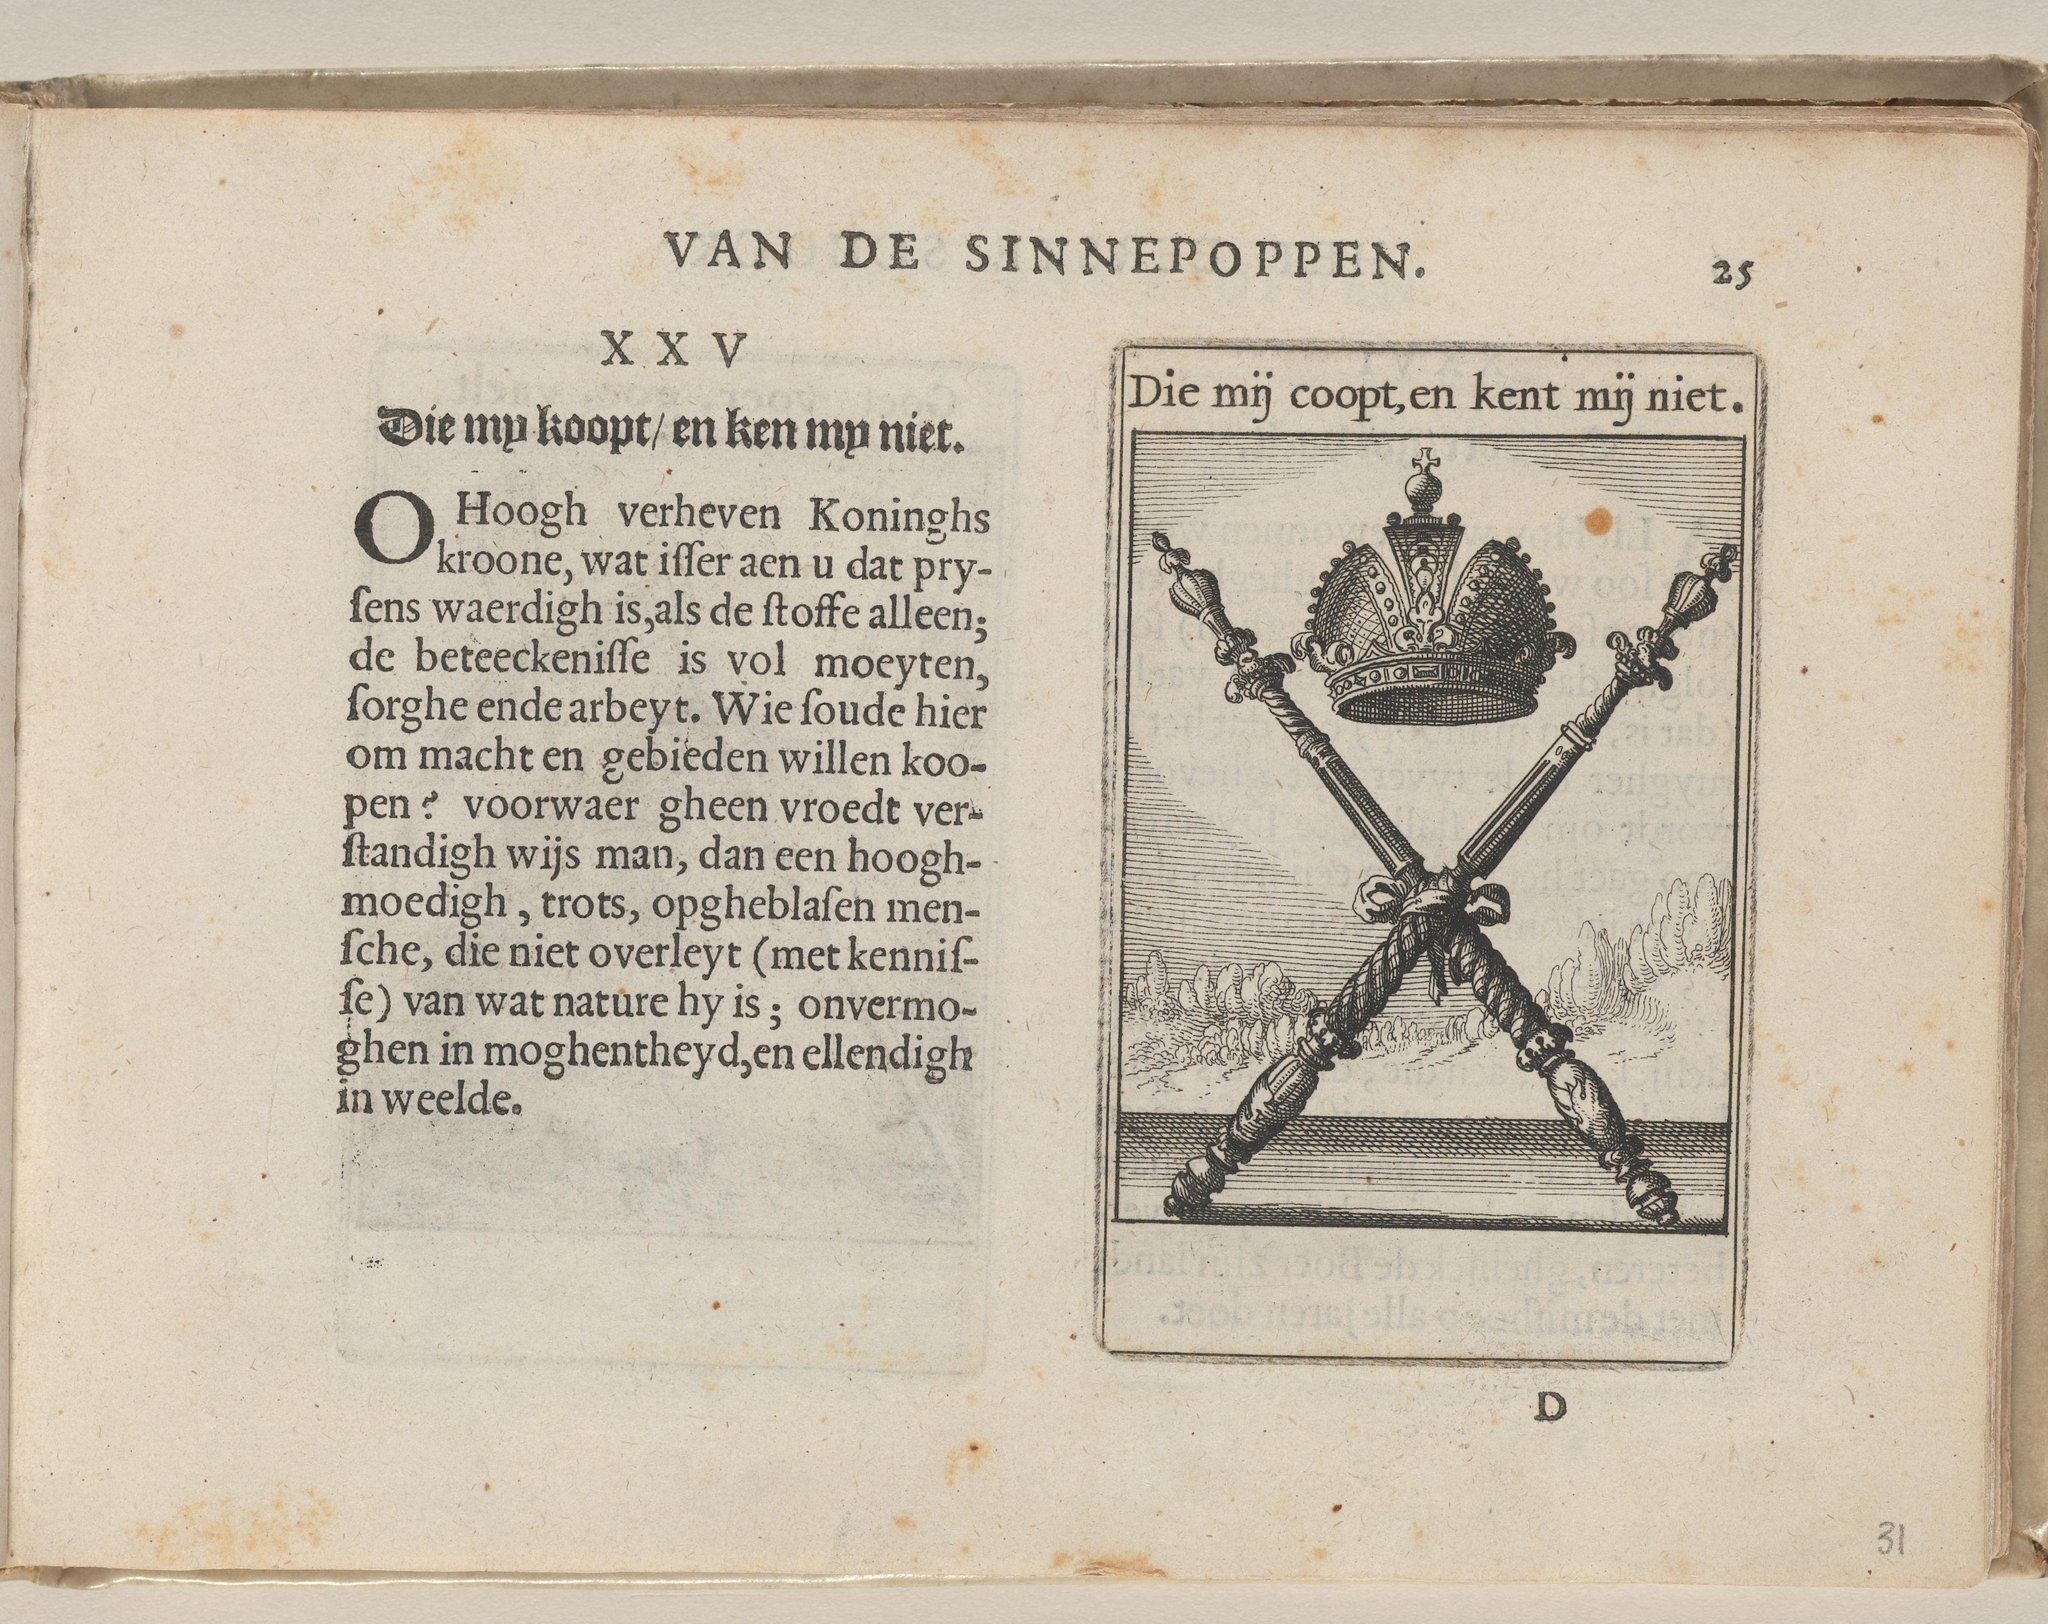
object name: print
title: XXV Die mij coopt, en kent mij niet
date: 1614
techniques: engraving, printing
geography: the hague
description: XXV Die mij coopt, en kent mij niet. Eerste schok. Onderdeel van 'Sinnepoppen', R. Visscher, 1614.